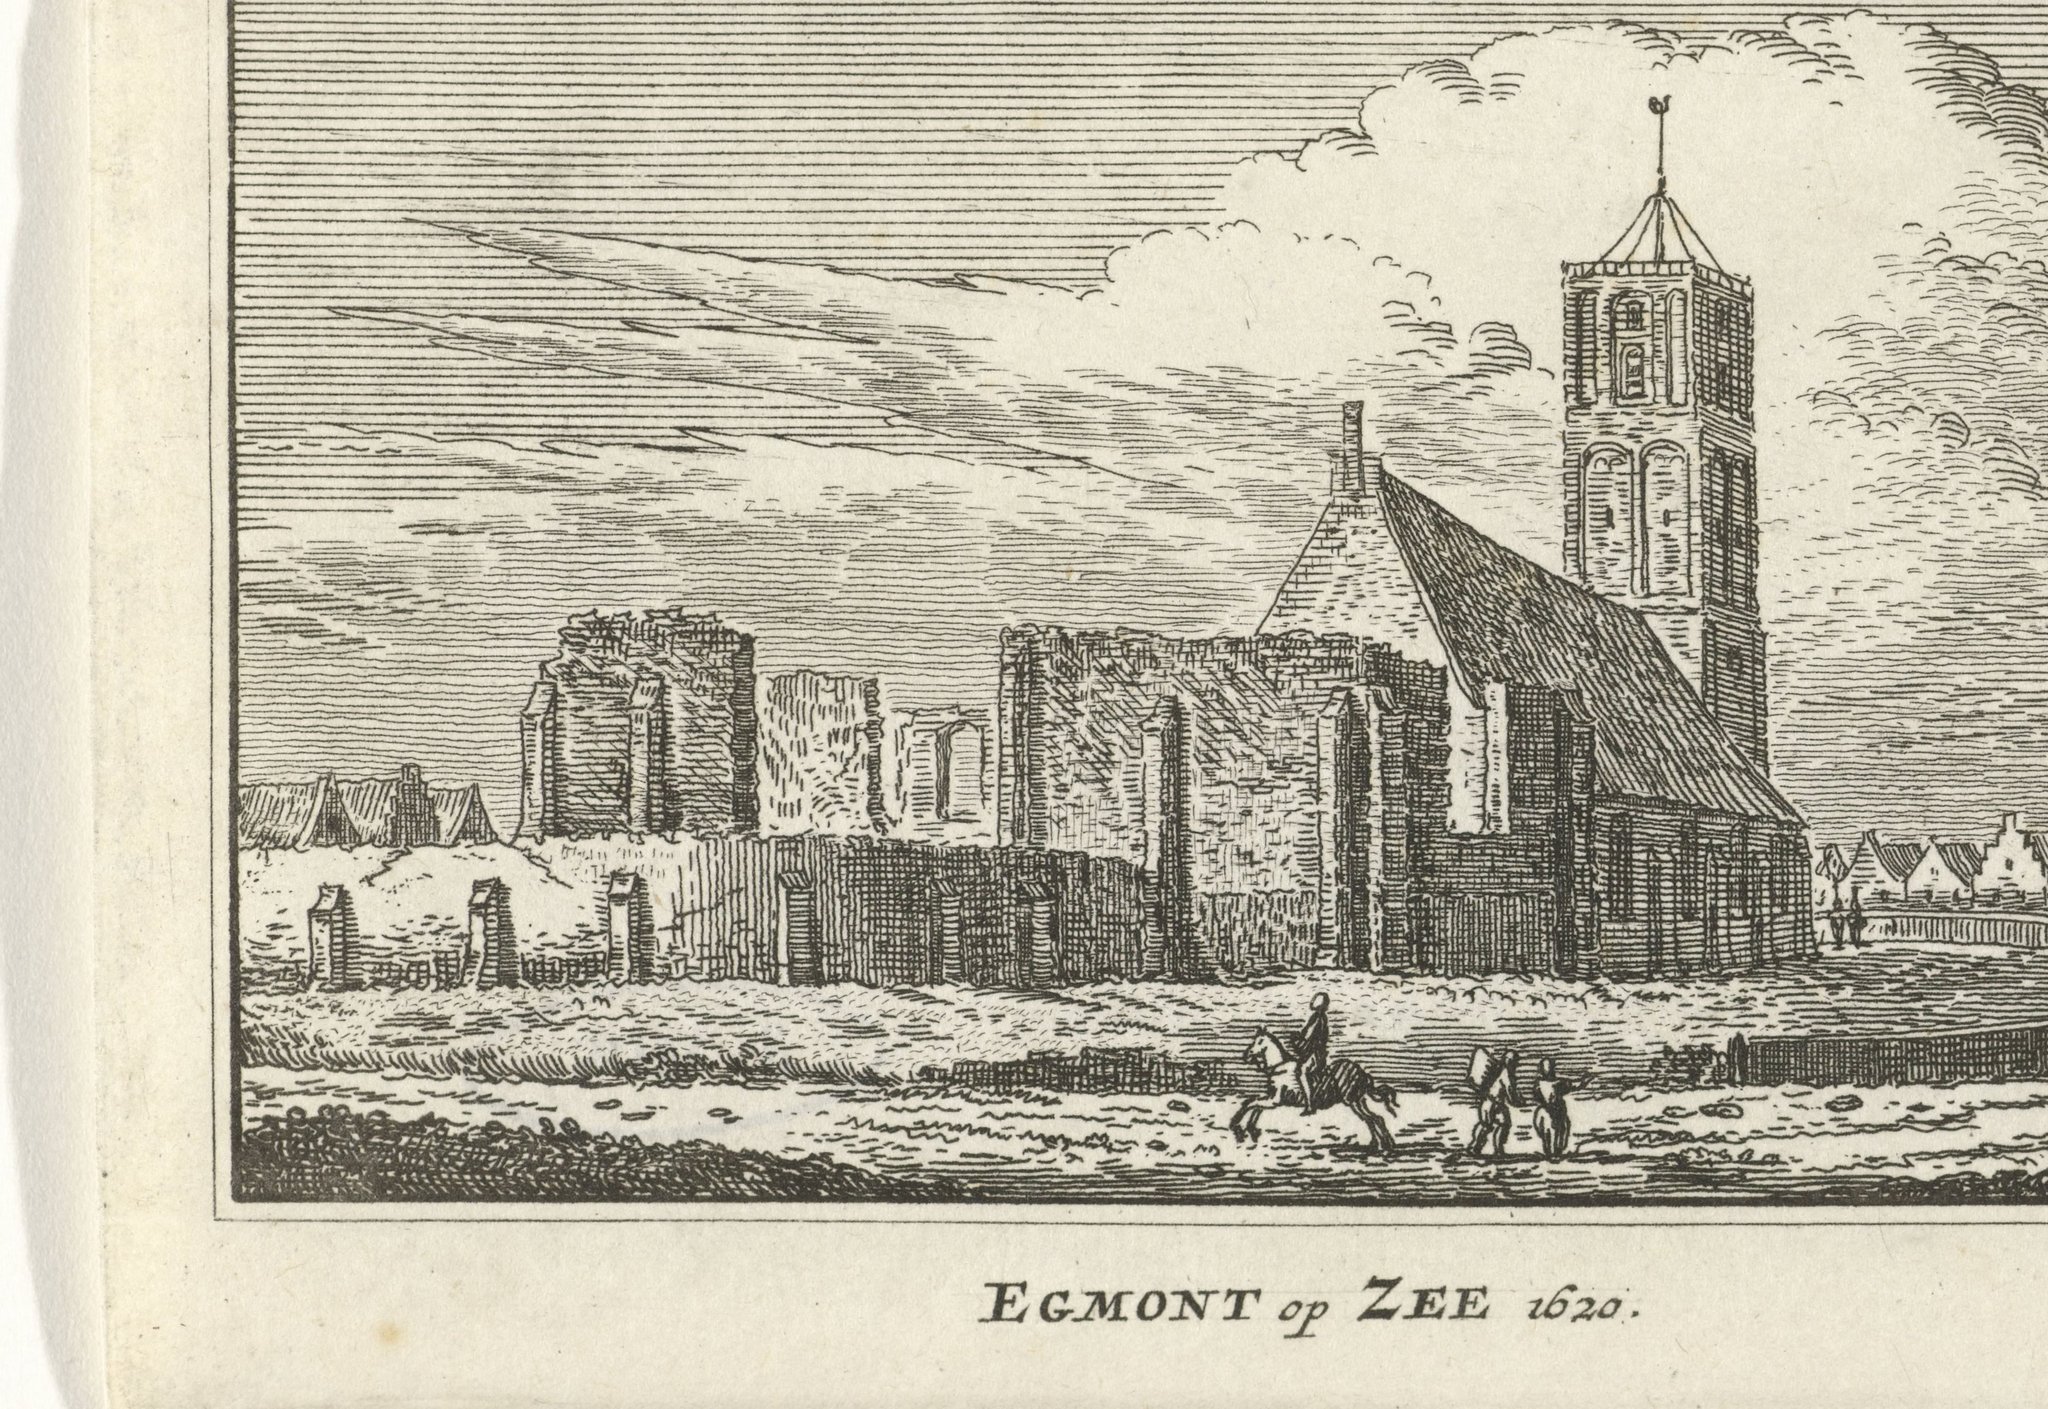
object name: book illustration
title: Gezicht op Egmond aan Zee, 1620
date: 1727-1733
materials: paper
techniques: etching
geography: amsterdam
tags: riding a horse, ass, or mule; rider, horseman, prospect of village, silhouette of village, church (exterior), 'en route', traveller under way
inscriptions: collector's mark: Lugt 2228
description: Illustratie uit: Abraham Rademaker, Matthaeus Brouërius van Niedek, Isaac Le Long, Kabinet van Nederlandsche en Kleefsche outheden en (...) voorname stads- en landgebouwen, Willem Barents en Antoni Schoonenburg: Amsterdam, 1727-1733, ill. nr. 41.